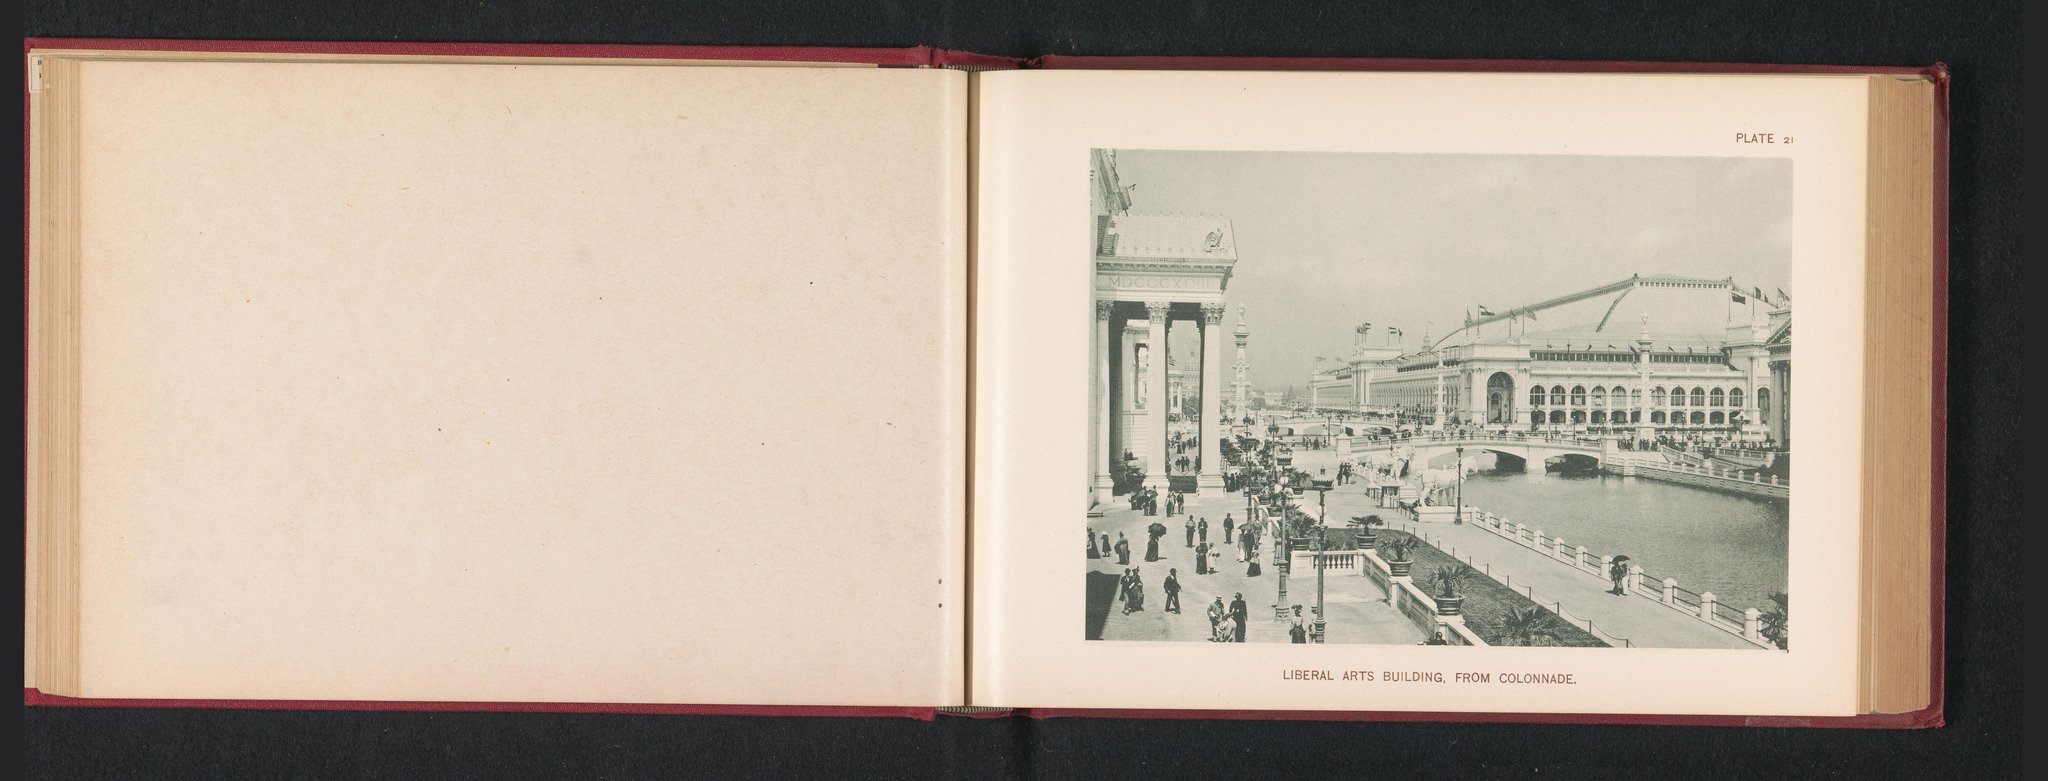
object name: page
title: Gezicht op het gebouw voor techniek en vrije kunsten op de World's Columbian Exposition in Chicago in 1893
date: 1893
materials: paper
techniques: photograph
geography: chicago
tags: world fair, world exhibition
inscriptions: number: ‘Plate 21’